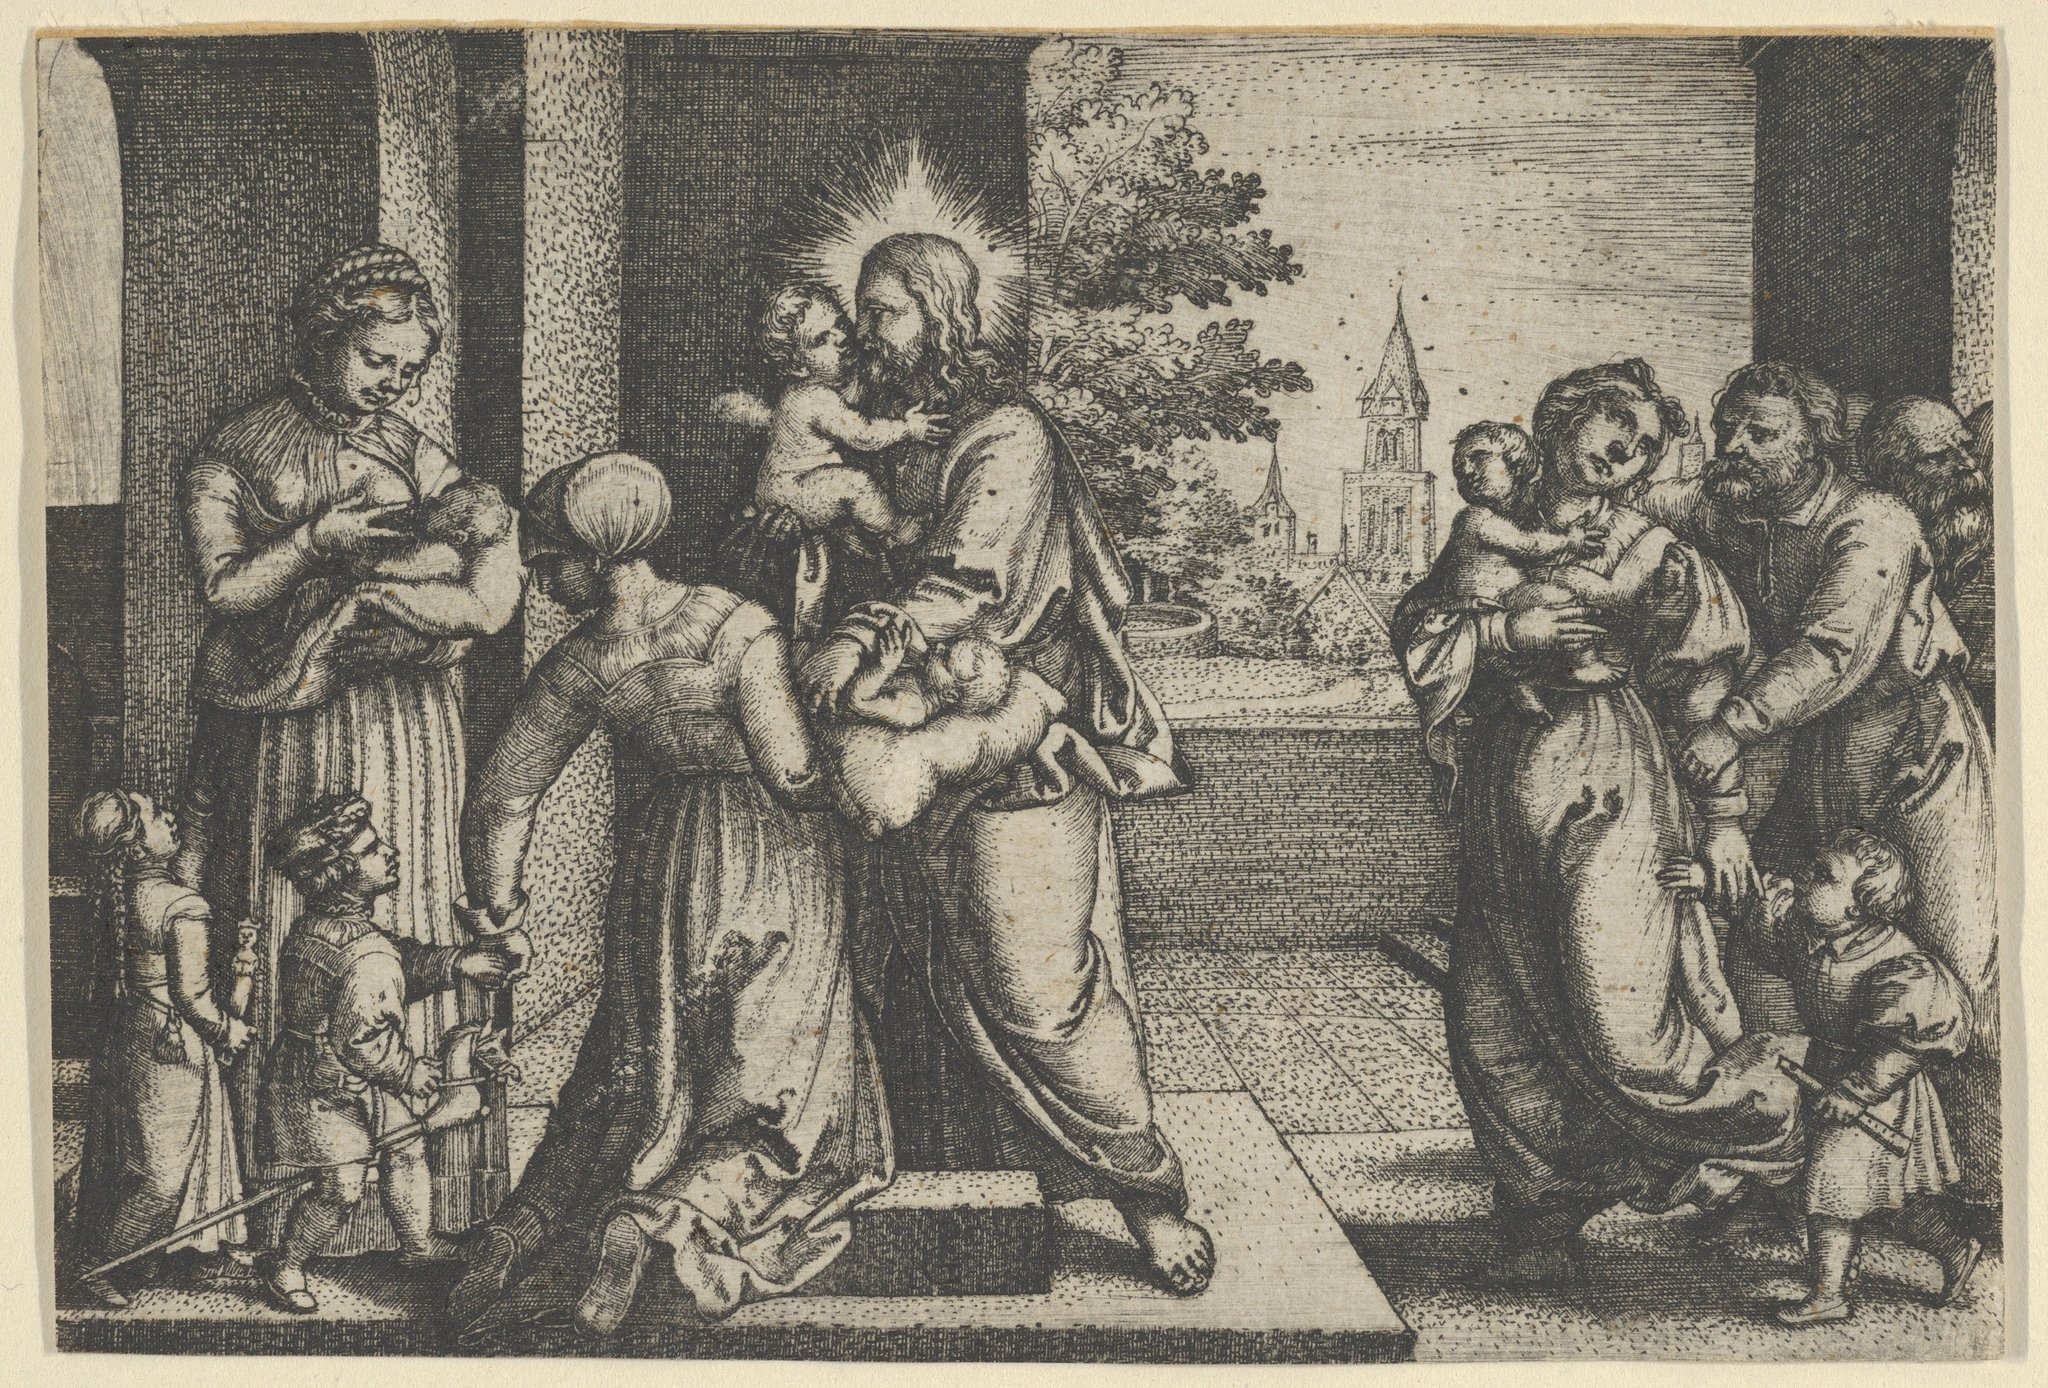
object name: print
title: Christ and the Children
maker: georg pencz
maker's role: artist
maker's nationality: german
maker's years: 1500-1550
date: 1543-1553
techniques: engraving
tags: children,women,christ